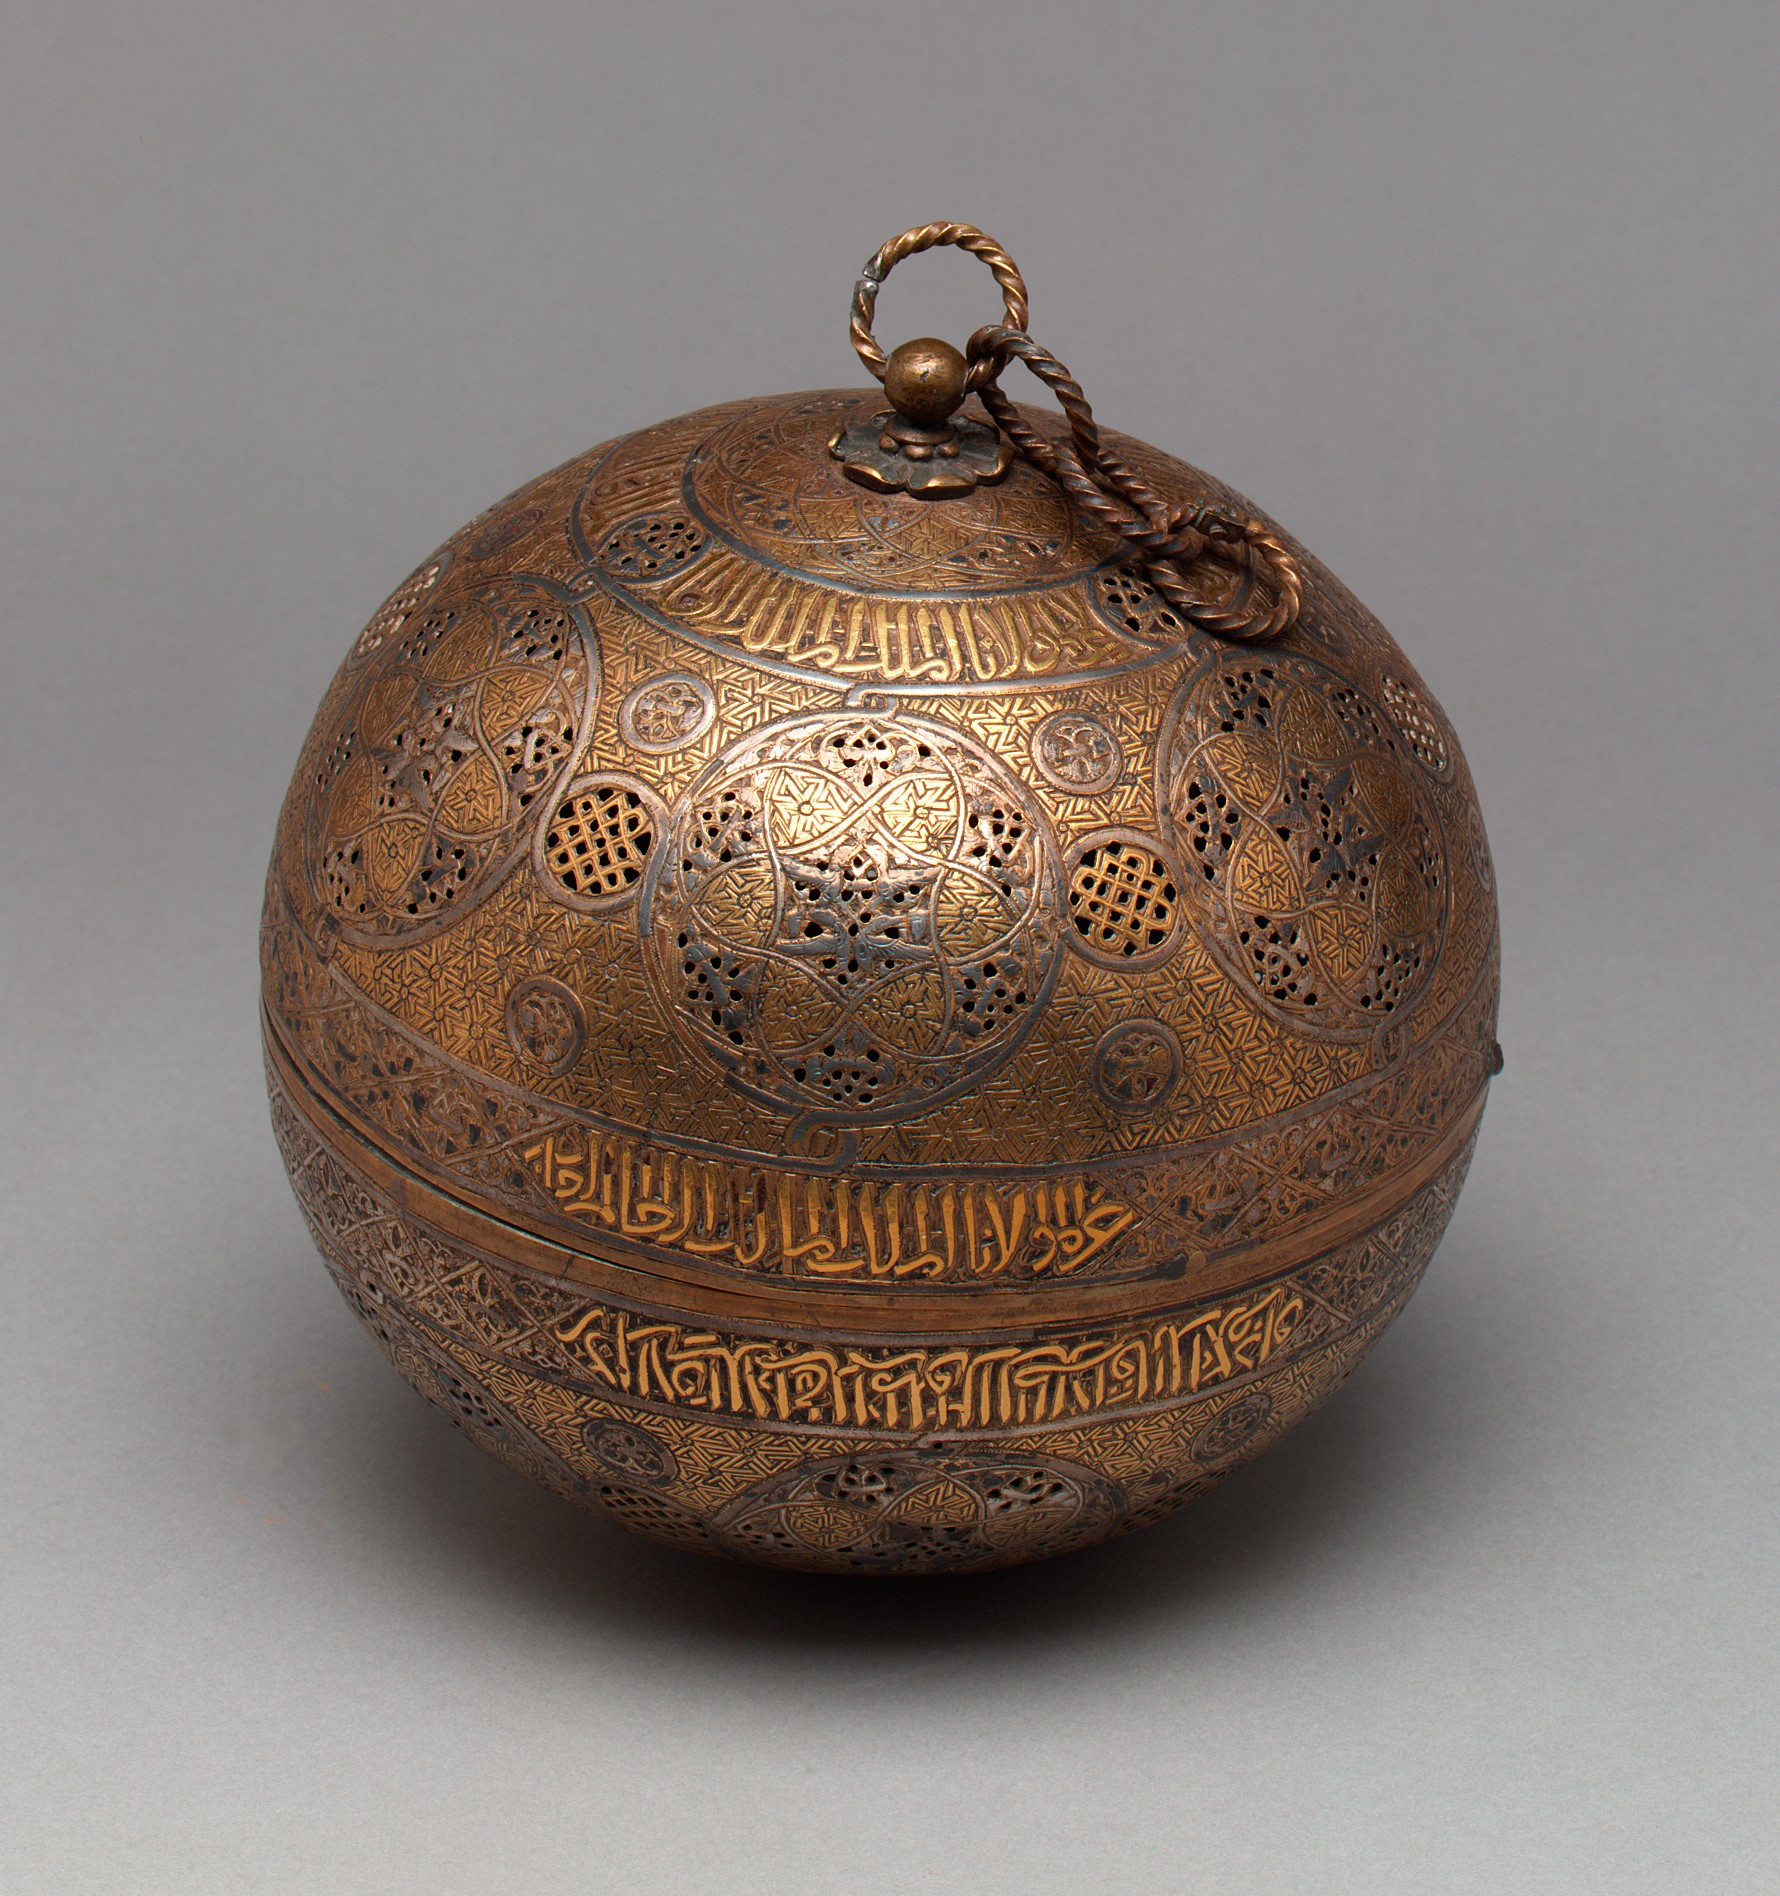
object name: incense burner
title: Pierced Globe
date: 1267-1333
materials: brass, gold, silver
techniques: chasing, inlay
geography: syria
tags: arabic